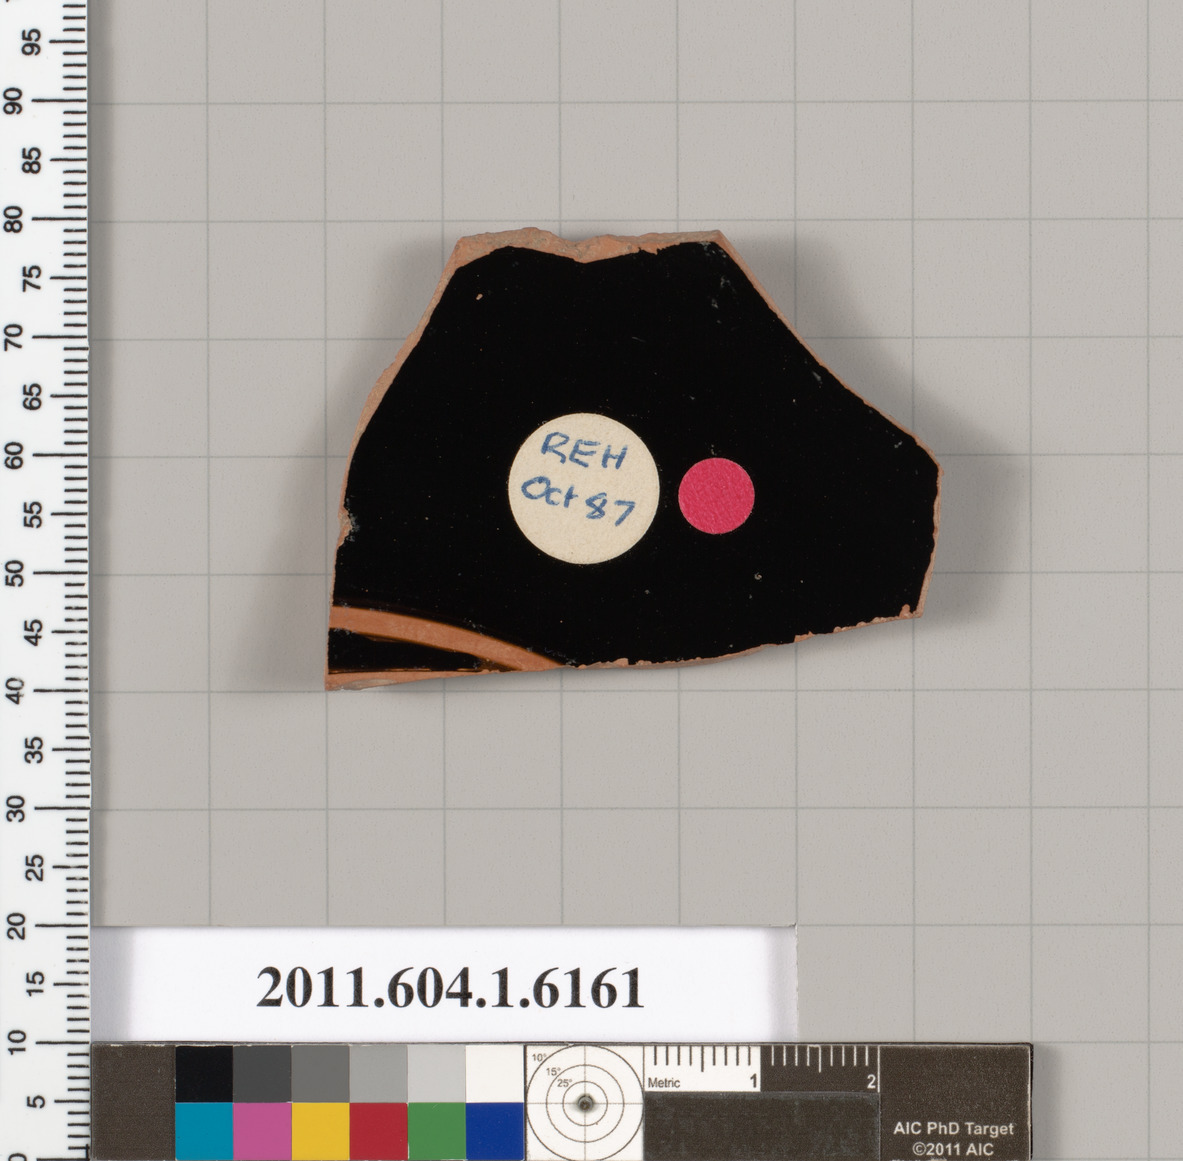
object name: kylix fragment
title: Terracotta fragment of a kylix (drinking cup)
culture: greek, attic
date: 520-500 BCE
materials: terracotta